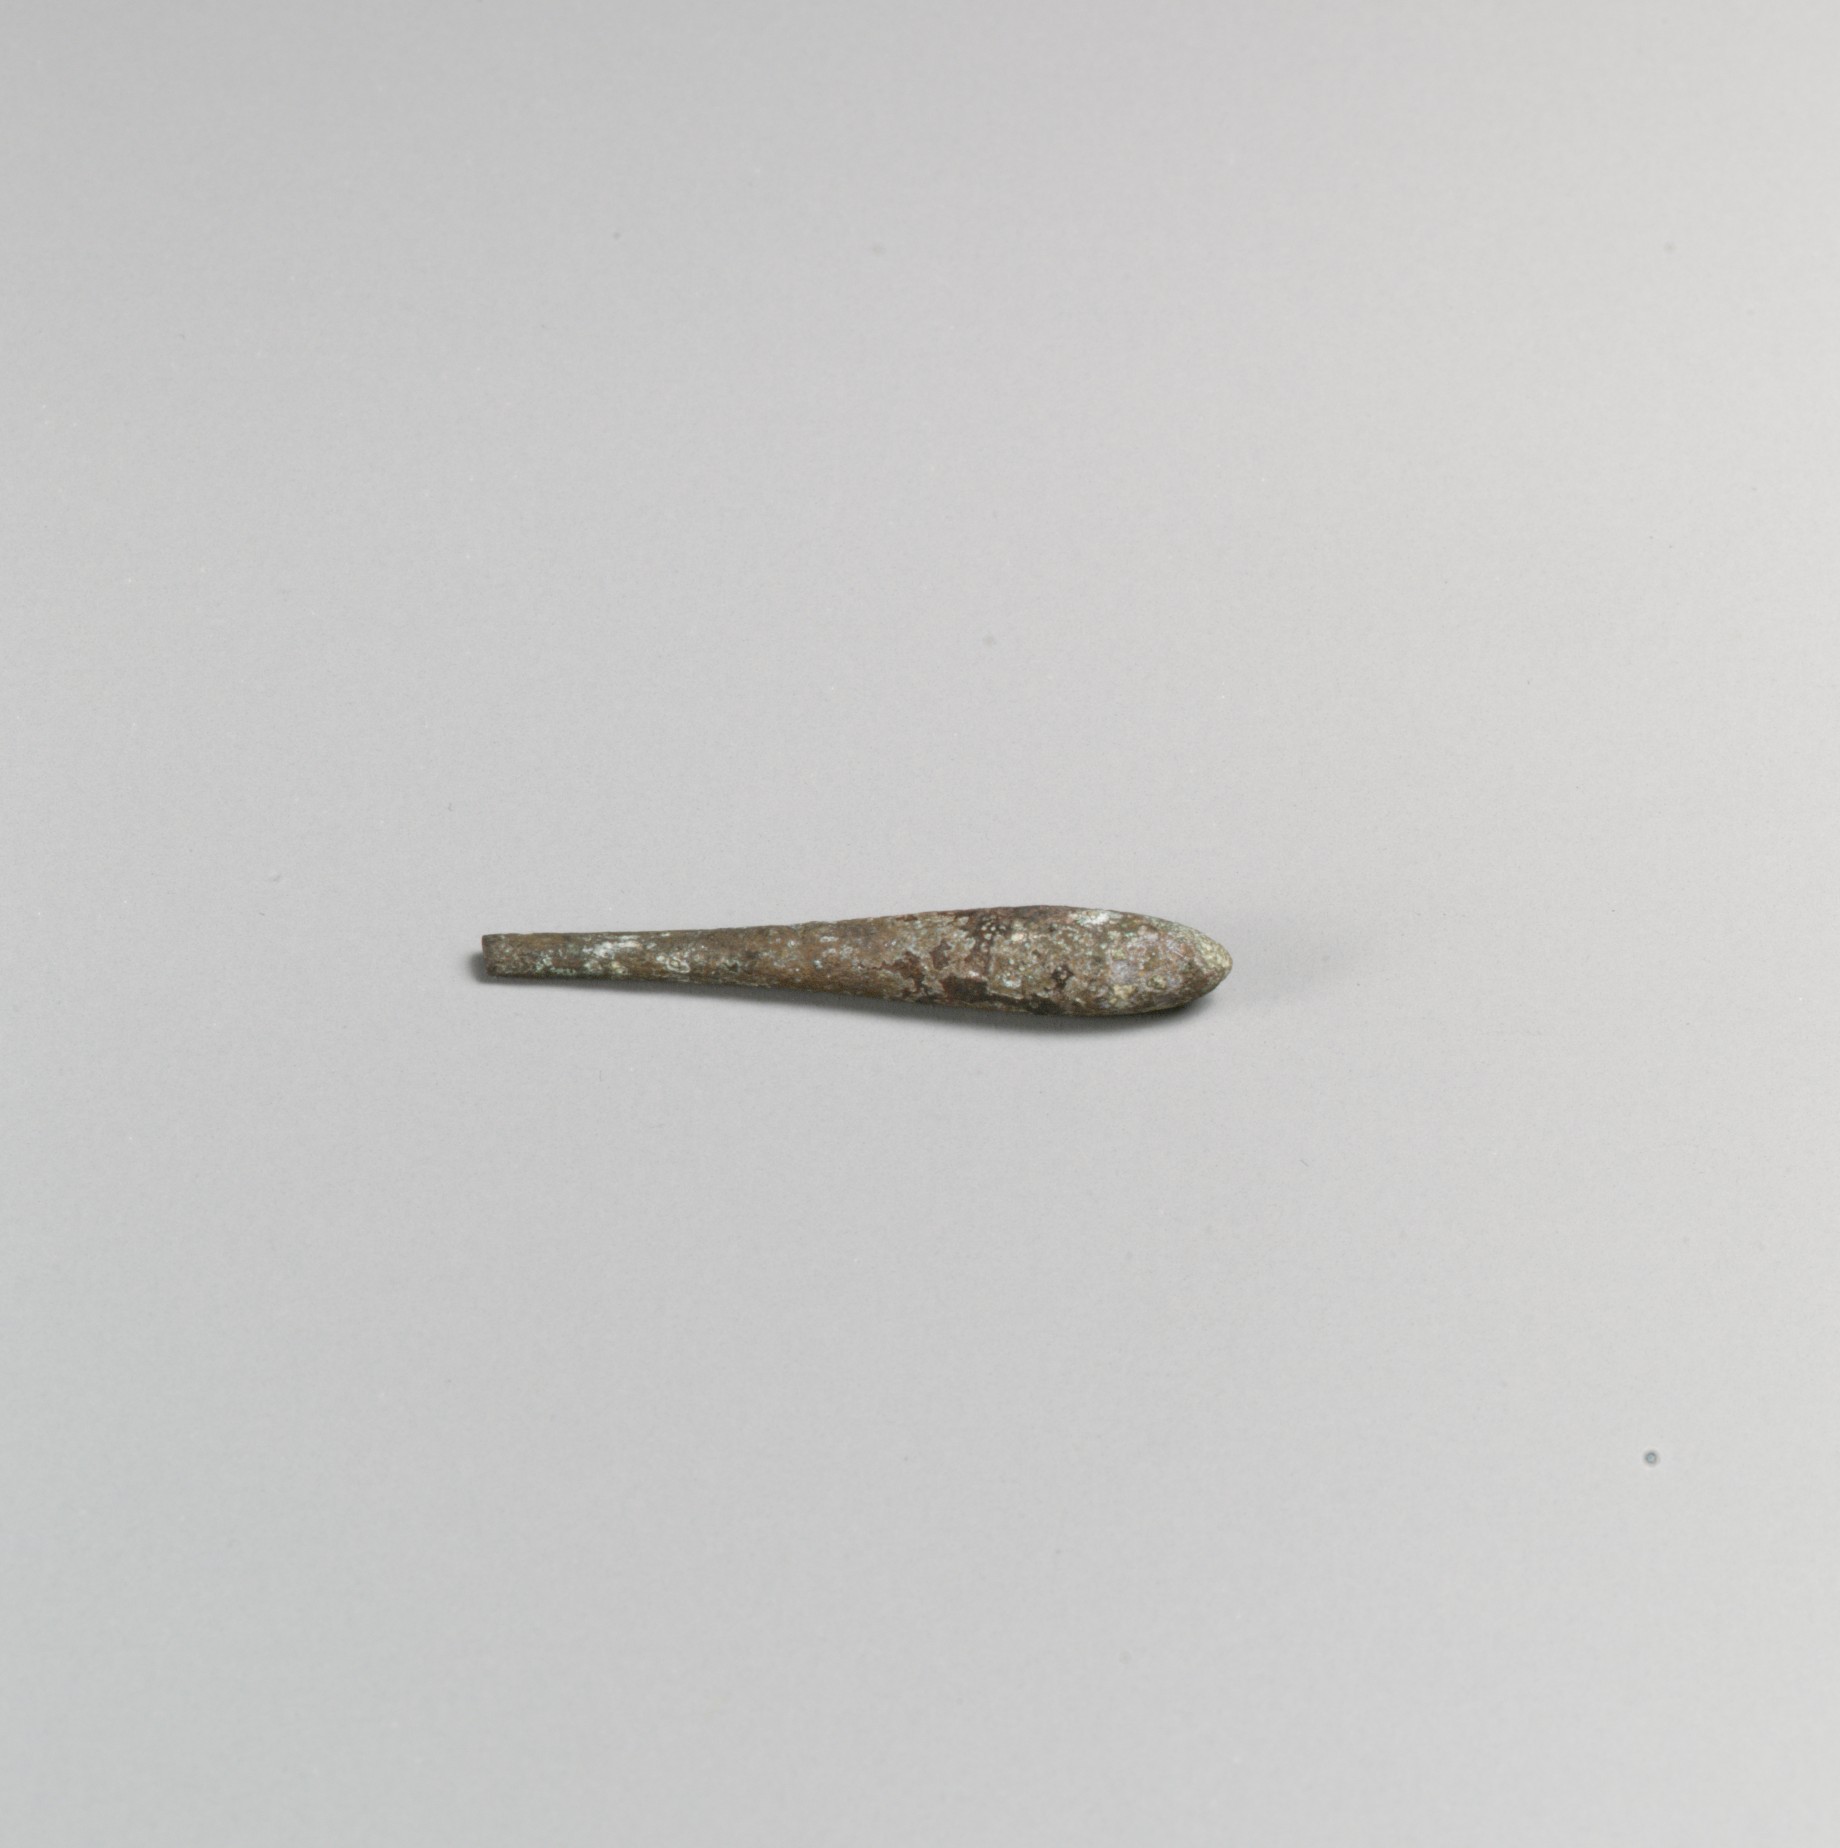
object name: probe, fragmentary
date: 7000 BCE-330 CE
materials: bronze